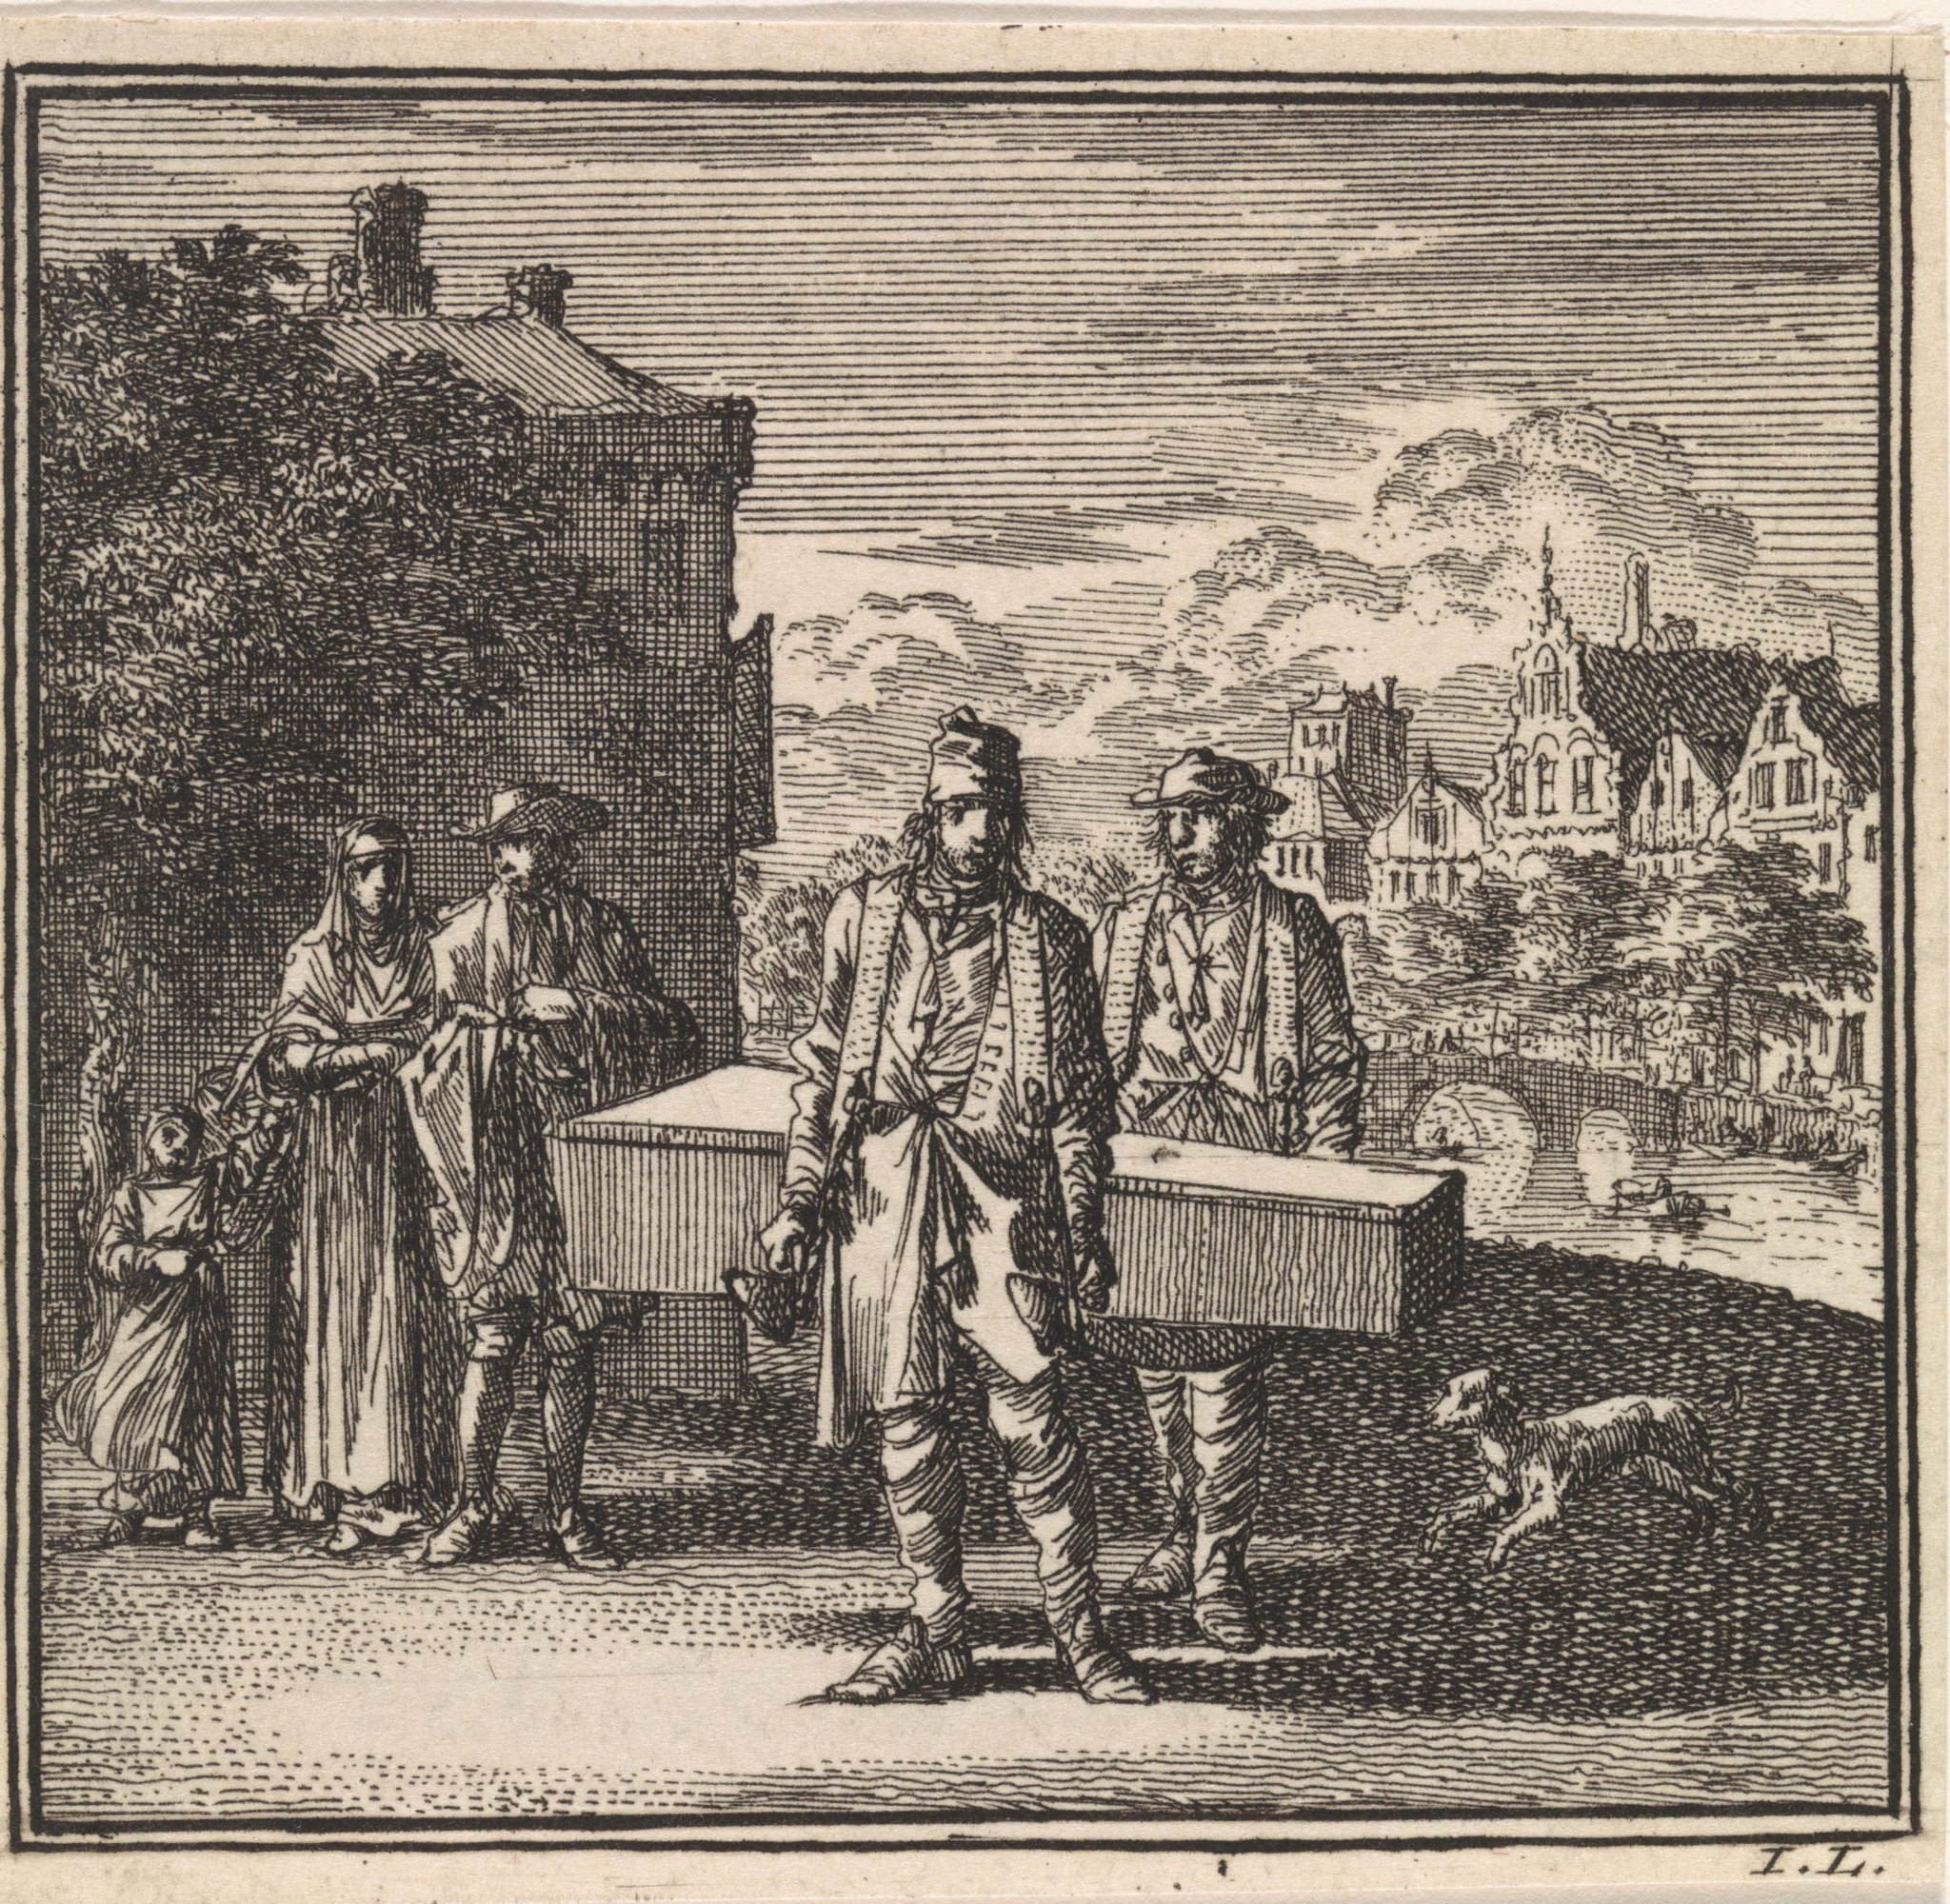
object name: book illustration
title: Doodskist wordt naar een sterfhuis gebracht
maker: jan luyken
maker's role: draughtsman, print maker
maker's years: 1649-1712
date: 1711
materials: paper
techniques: etching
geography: amsterdam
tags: coffin, dog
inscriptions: collector's mark: Lugt 2228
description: Illustratie voor: Luyken, Jan. De Bykorf des Gemoeds. Amsterdam: Pieter Arentsz. II (wed.) en Cornelis van der Sys, 1711, p. 394.